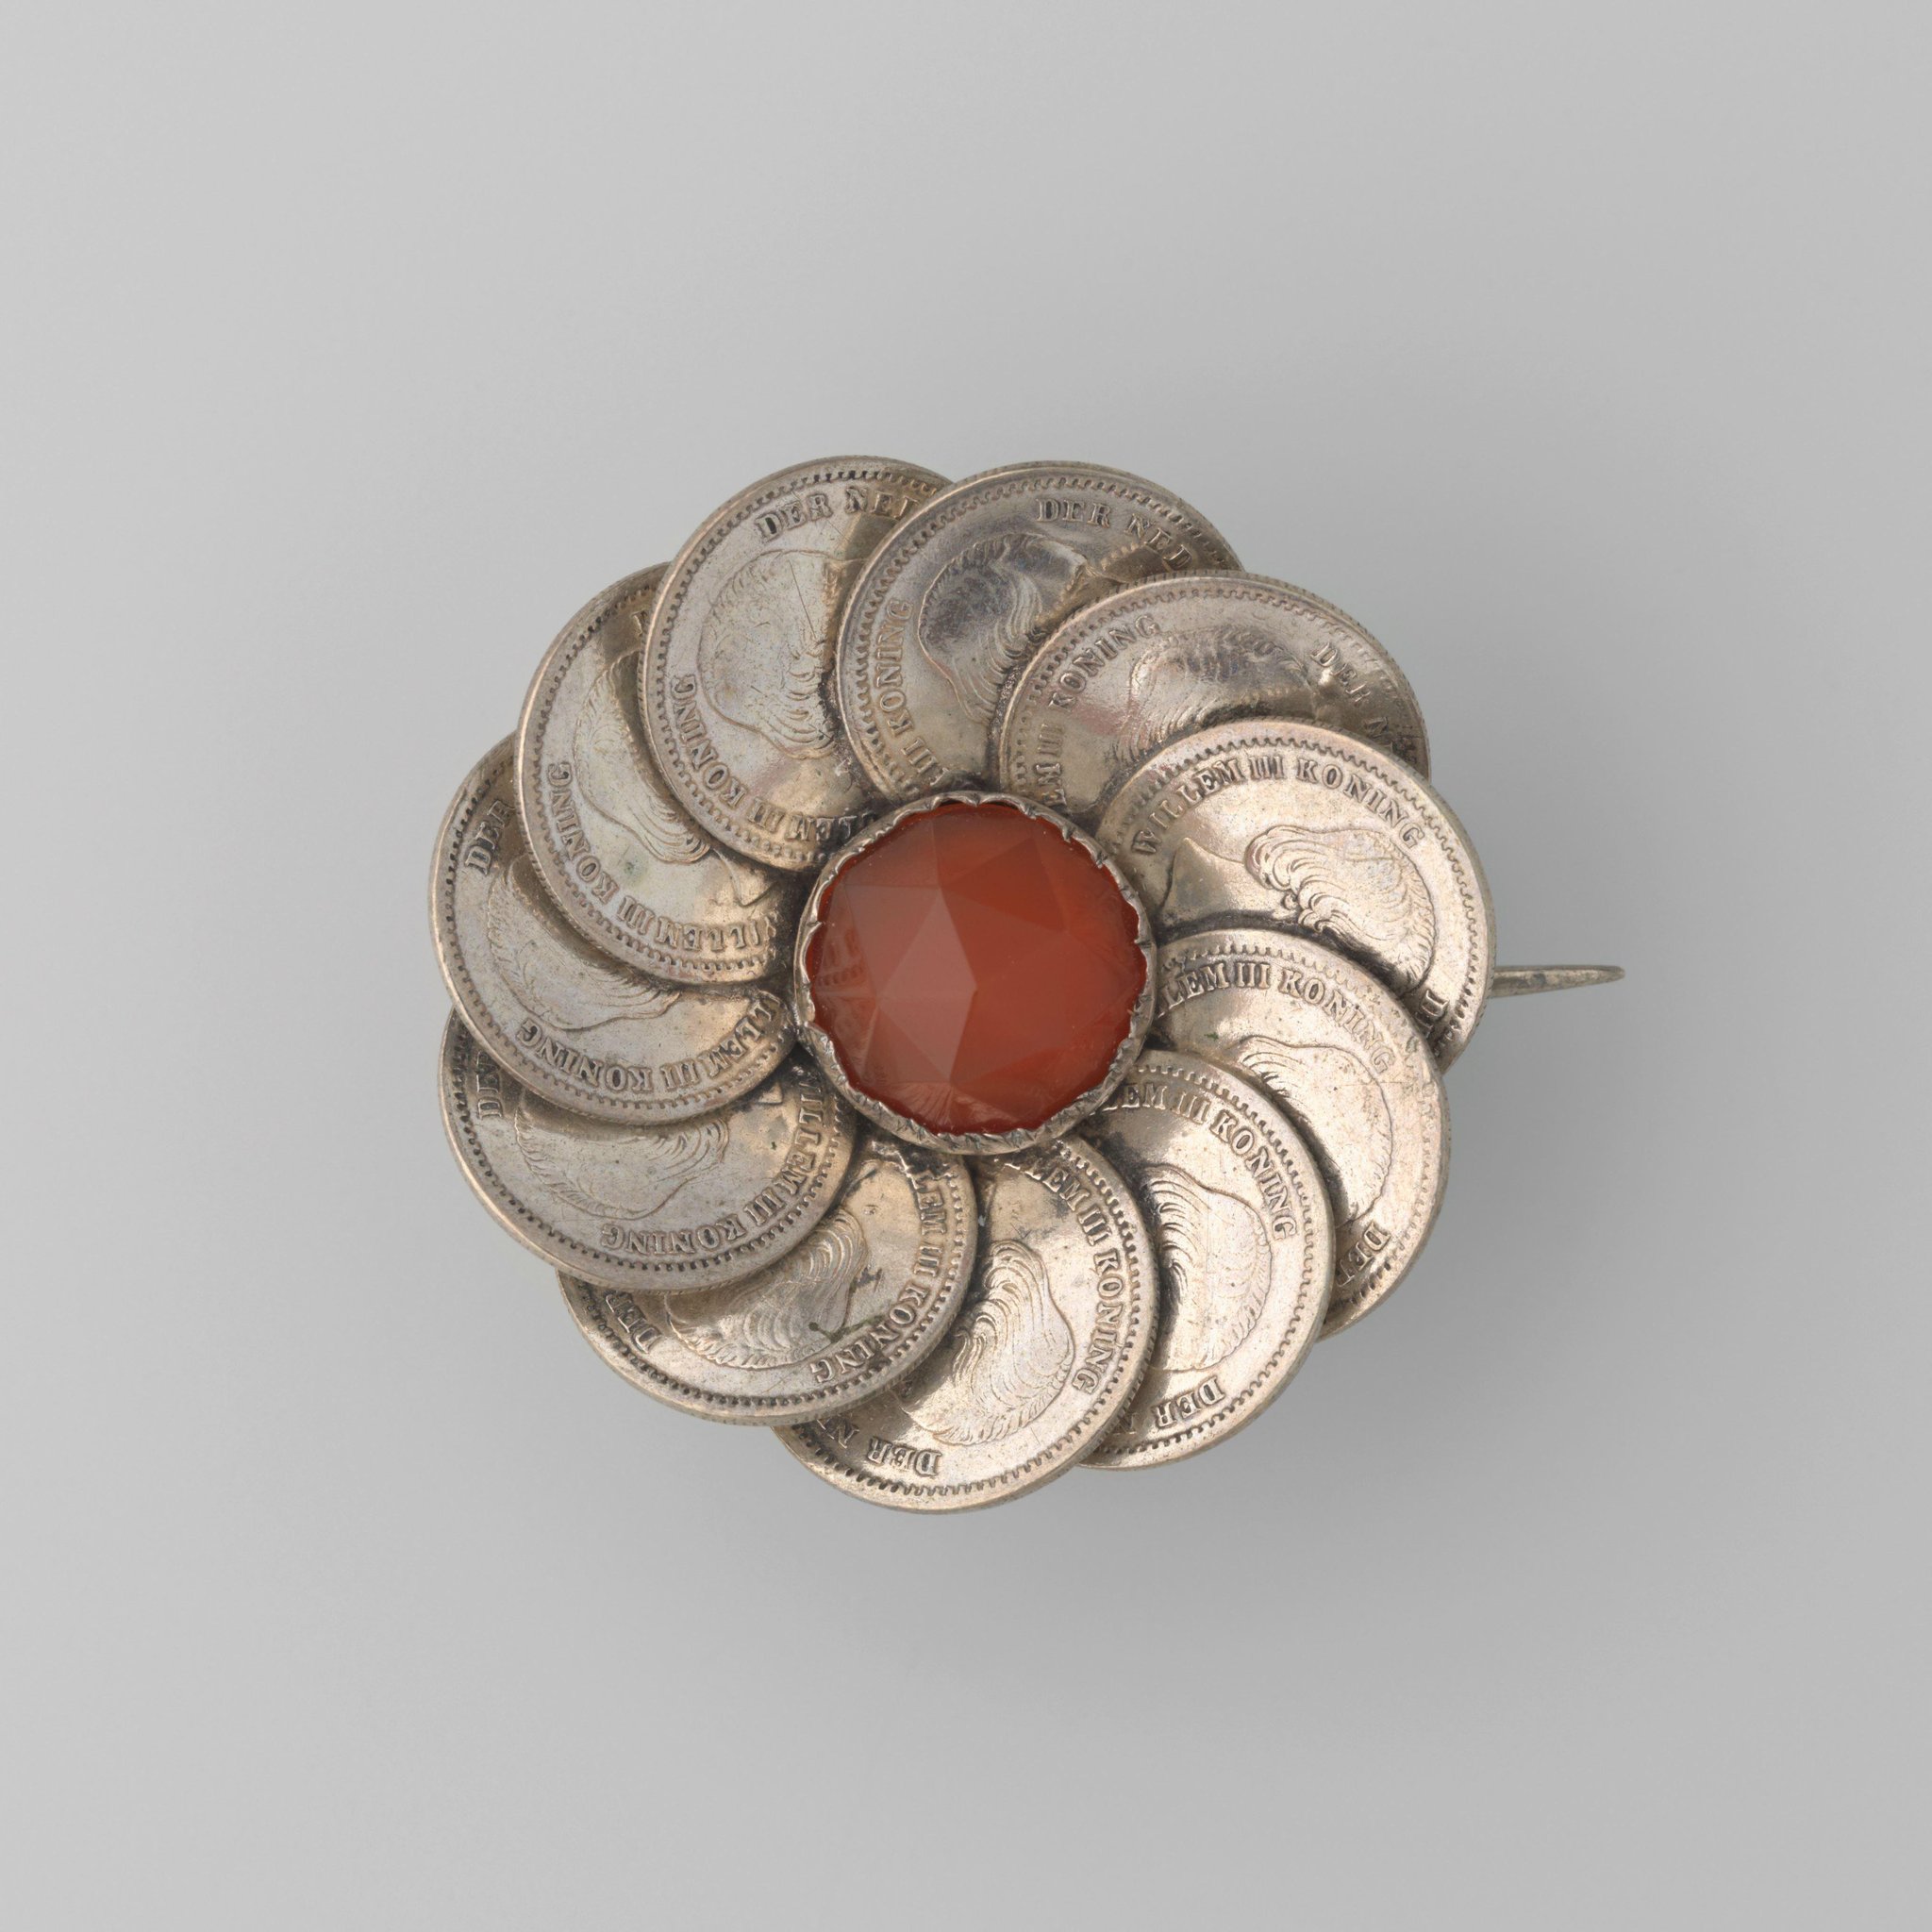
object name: brooch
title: Broche van zilveren munten en carneool van Willem III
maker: Anonymous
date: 1930-1940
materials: gemstone, silver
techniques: faceting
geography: netherlands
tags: brussels, willem iii (koning der nederlanden)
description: Broche in bloemvorm van elf zilveren munten van 5 cent met Willem III en centraal een rond gefacetteerde carneool, voorzien van een haaksluiting.